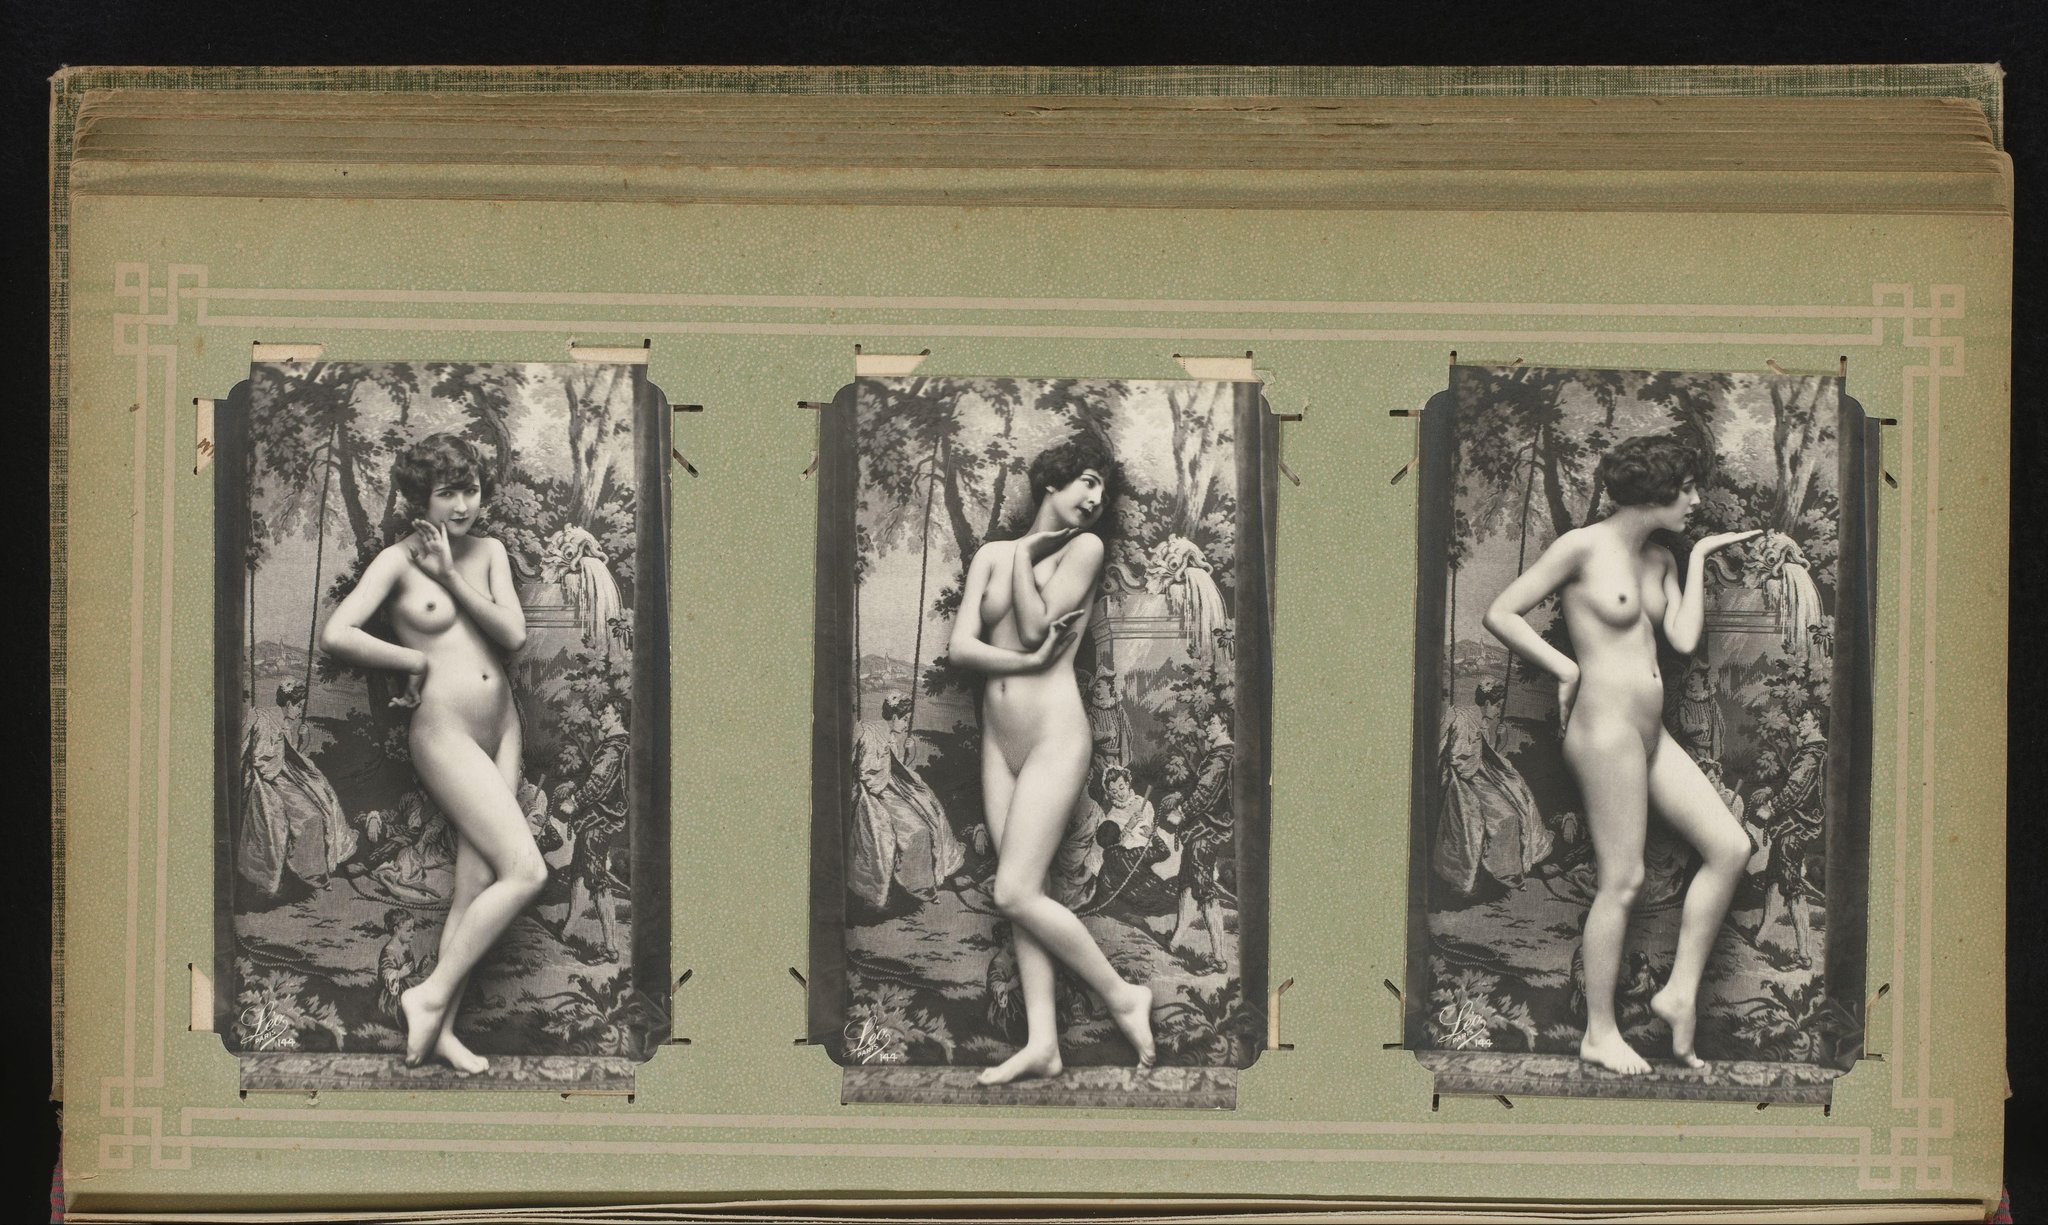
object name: photograph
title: Drie portretten van een naakte vrouw voor een decor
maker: léo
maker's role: fotograaf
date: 1900-1930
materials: cardboard, photographic support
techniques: gelatin silver print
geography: paris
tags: set, scenery ~ stage, historical persons - bb - woman, woman (showing herself) undressed, quasi-nude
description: Deze foto's maken deel uit van een album.